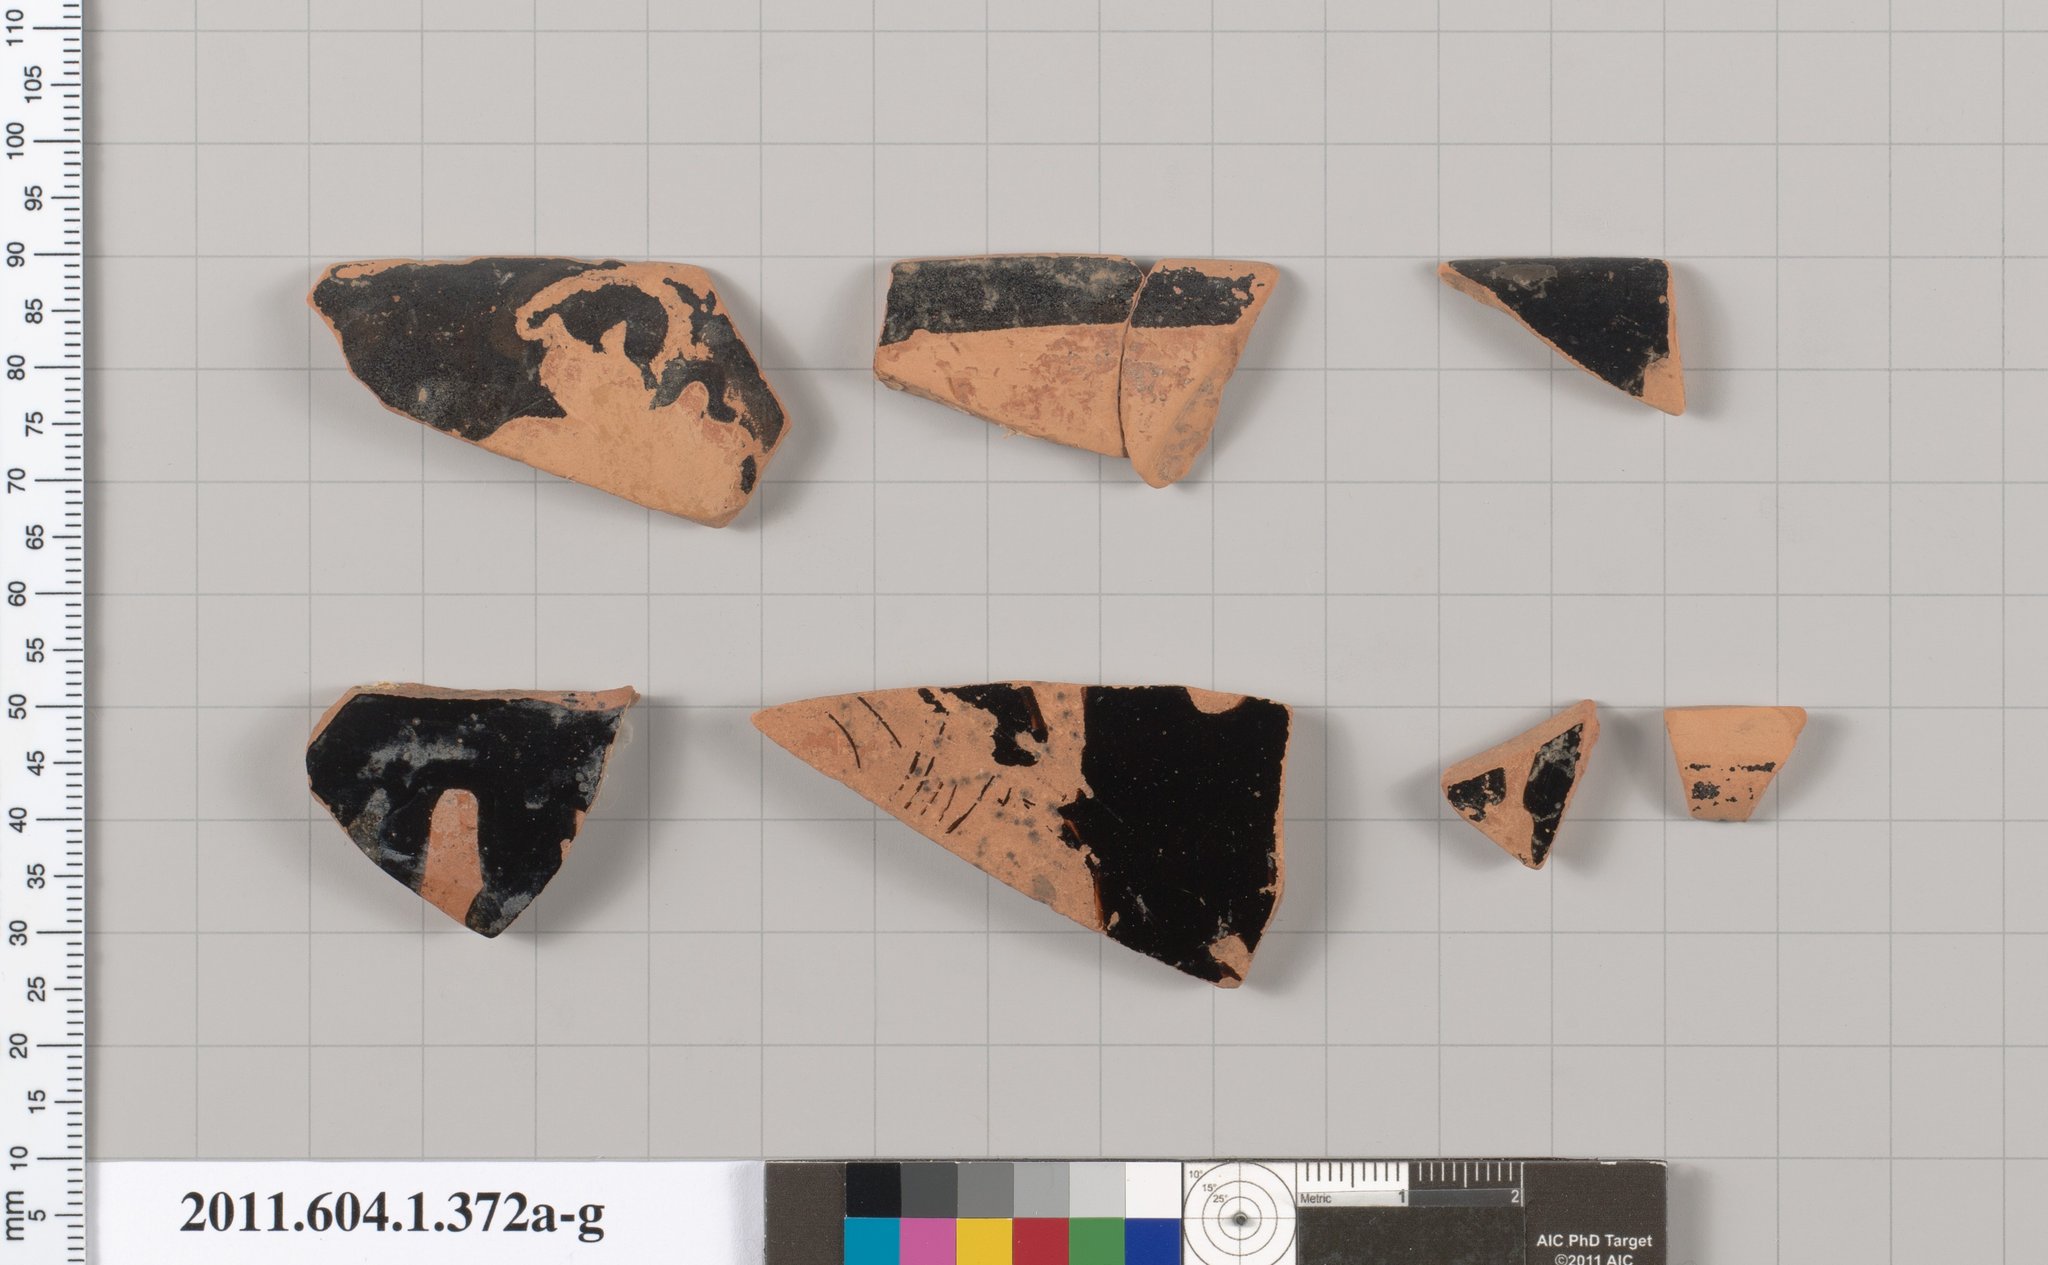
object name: kylix fragment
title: Terracotta fragments of a kylix (drinking cup)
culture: greek, attic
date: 467-435 BCE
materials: terracotta